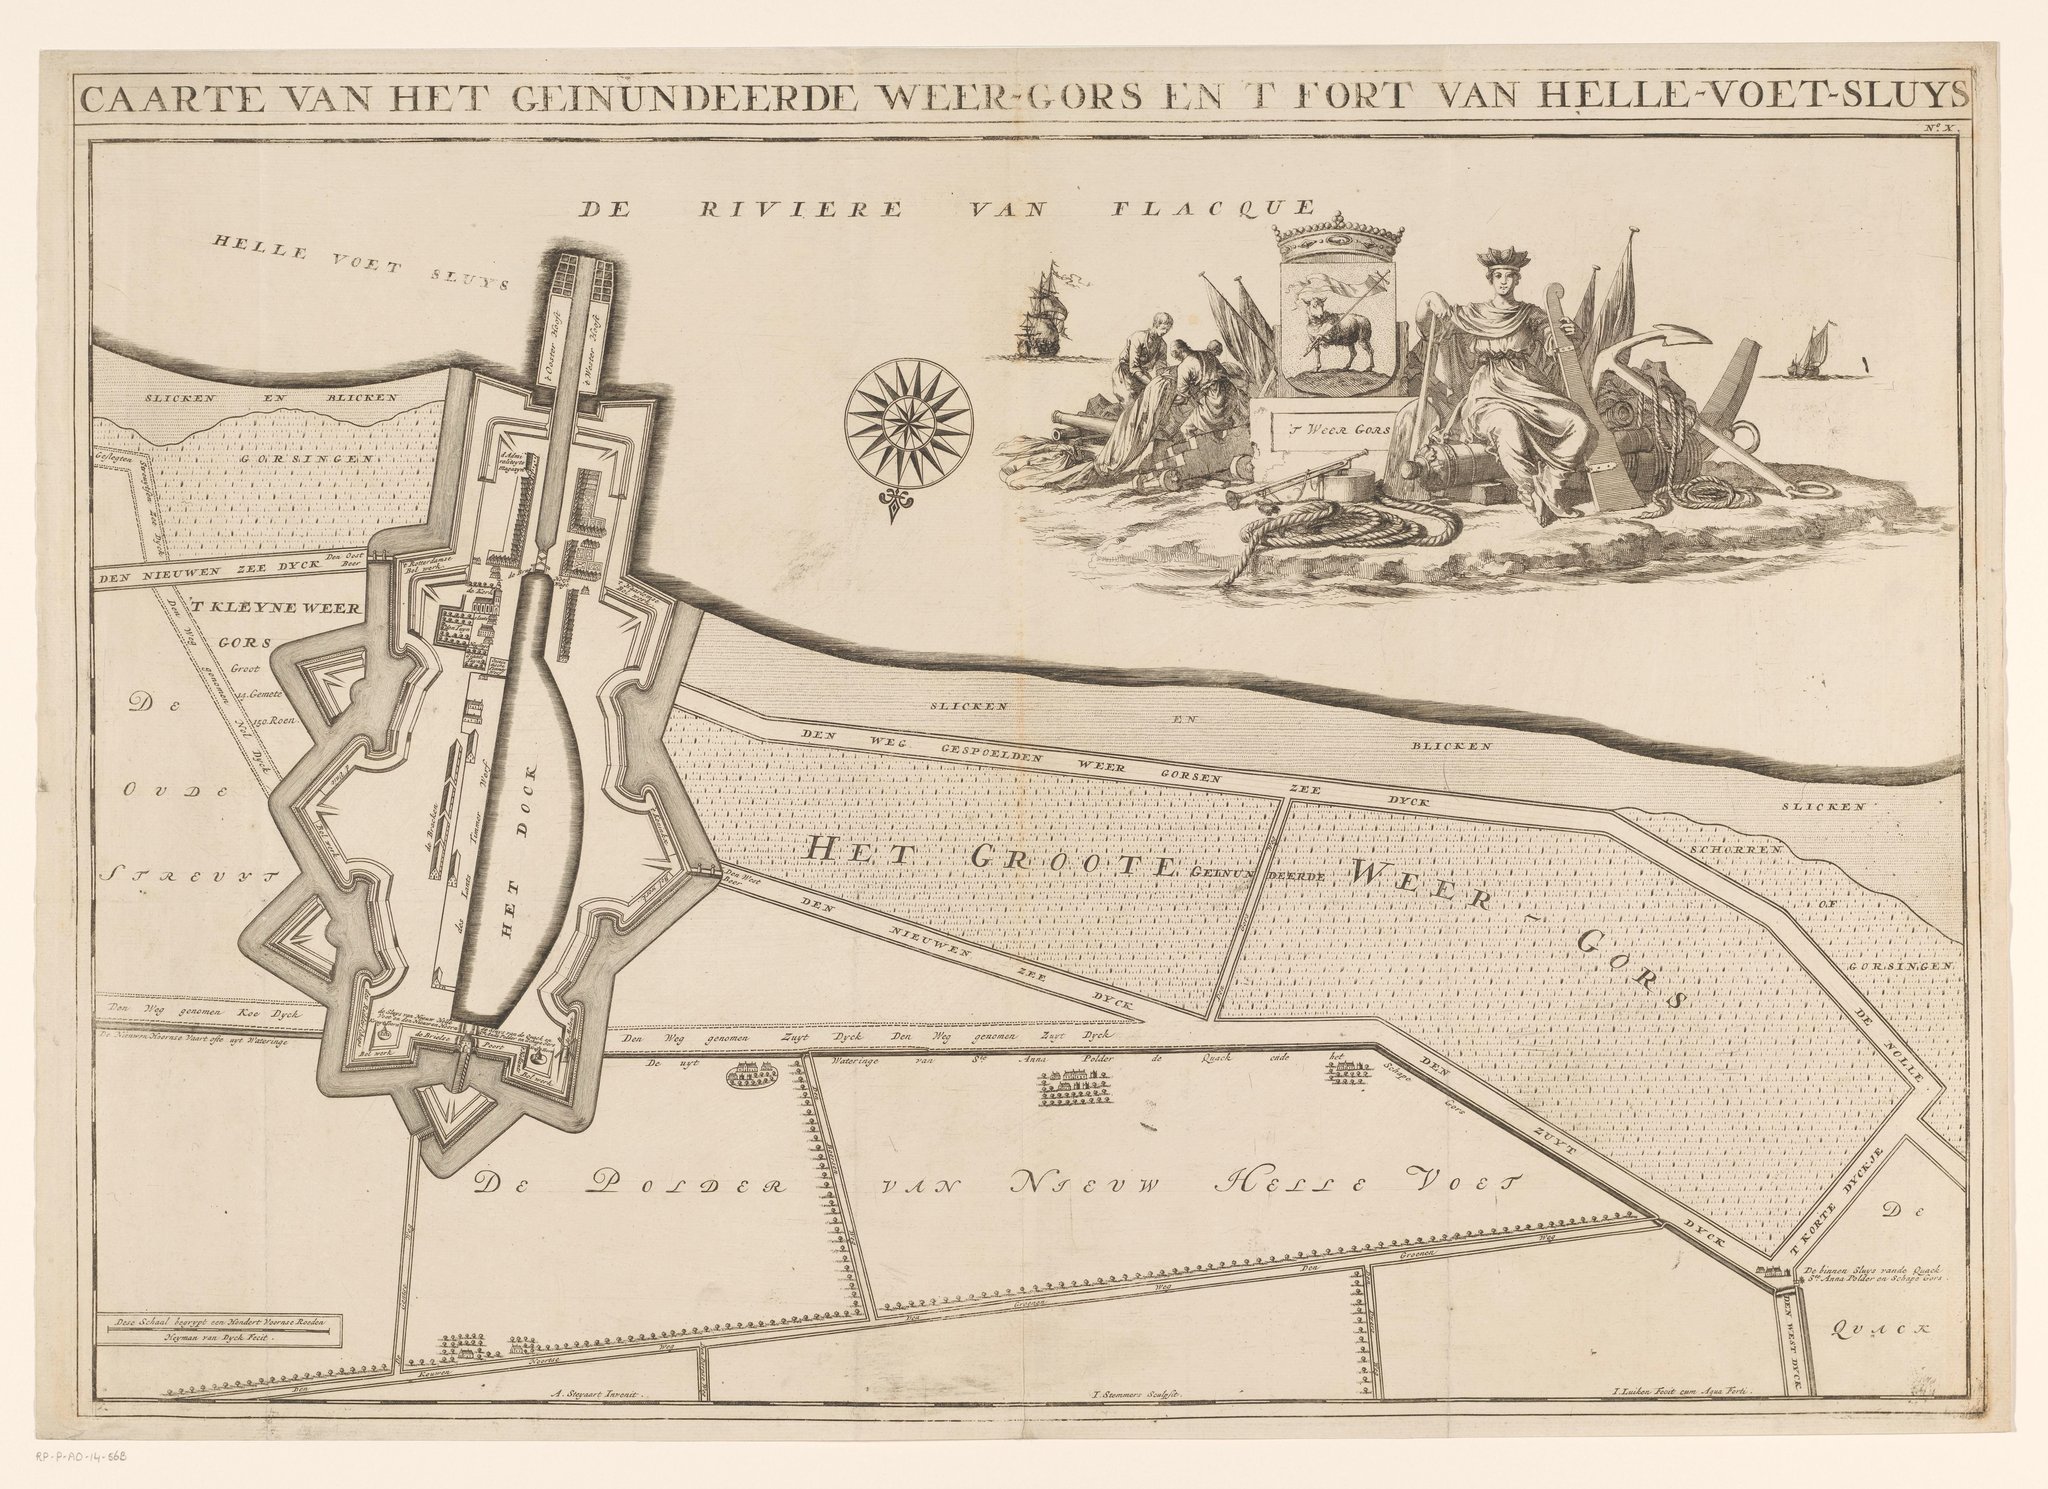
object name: print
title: Caarte van het geinundeerde Weer-gors en 't fort van Helle-Voet-Sluys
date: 1701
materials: paper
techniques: engraving, etching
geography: amsterdam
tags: coat of arms (as symbol of the state, etc.), maps of separate countries or regions, maps of cities, 'navigatione' (ripa), hellevoetsluis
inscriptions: collector's mark: Lugt 19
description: Deze kaart is onderdeel van het zogenaamde 'Voorne Caart-boeck' / 'Caartboeck van Voorne', dat bestaat uit een titelpagina (zie RP-P-1942-347), drie algemene kaarten (van Oost-, West- en Zuid-Voorne)* en dertig detailkaarten. Het kaartboek werd vervaardigd in opdracht van de Staten van Voorne en werd in 1701 uitgegeven. Een deel van de koperplaten is bewaard gebleven en in de negentiende en twintigste eeuw gebruikt voor herdrukken. *Over de naam Voorne kan verwarring ontstaan omdat de betekenis door de eeuwen heen is veranderd. Vroeger stonden de (voormalige) eilanden Voorne, Goeree en Overflakkee – allen historisch gezien onderdeel van het Land van Voorne – bekend als respectievelijk Oost-, West- en Zuid-Voorne.